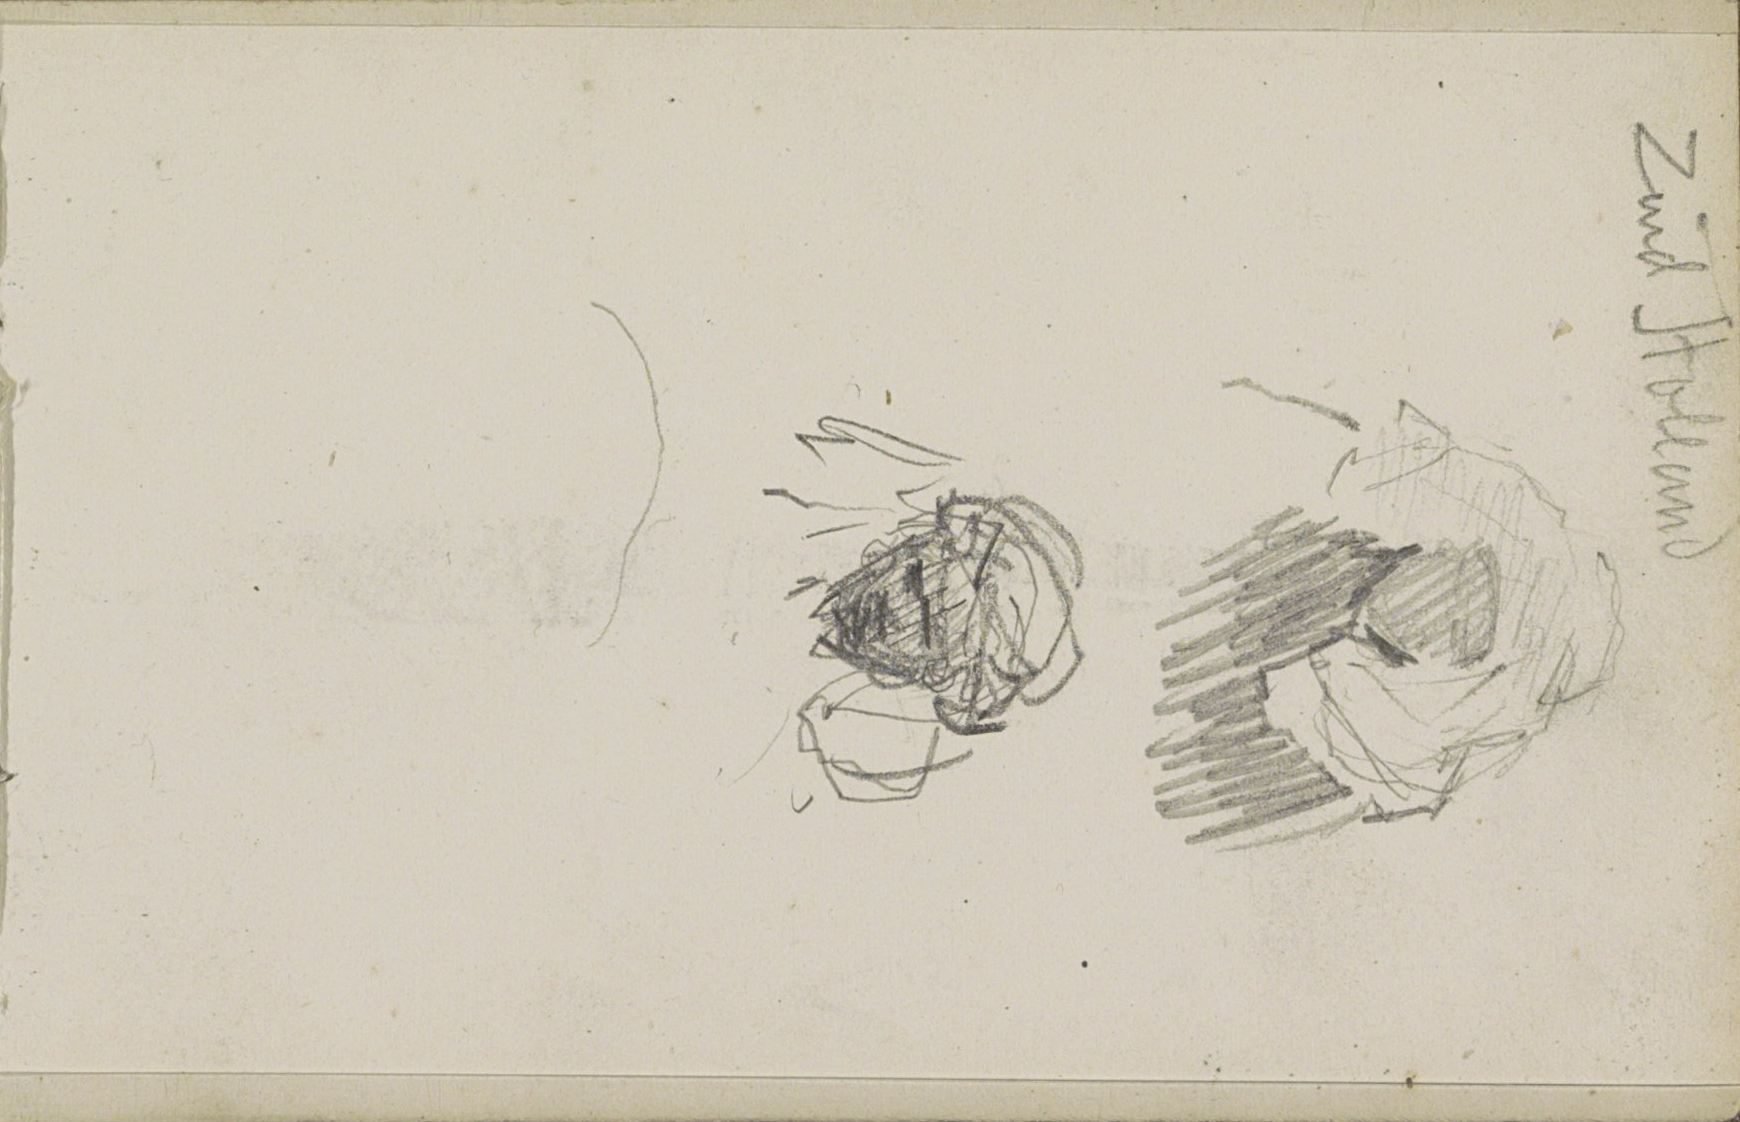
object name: sketchbook leaf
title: Twee koppen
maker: george clausen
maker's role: draughtsman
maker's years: 1852-1912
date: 1875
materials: paper, pencil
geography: south holland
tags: head (human), head-gear: hat (+ men's clothes)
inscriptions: annotation: ‘Zuid Holland’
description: Blad 5 recto uit een schetsboek met 38 bladen.